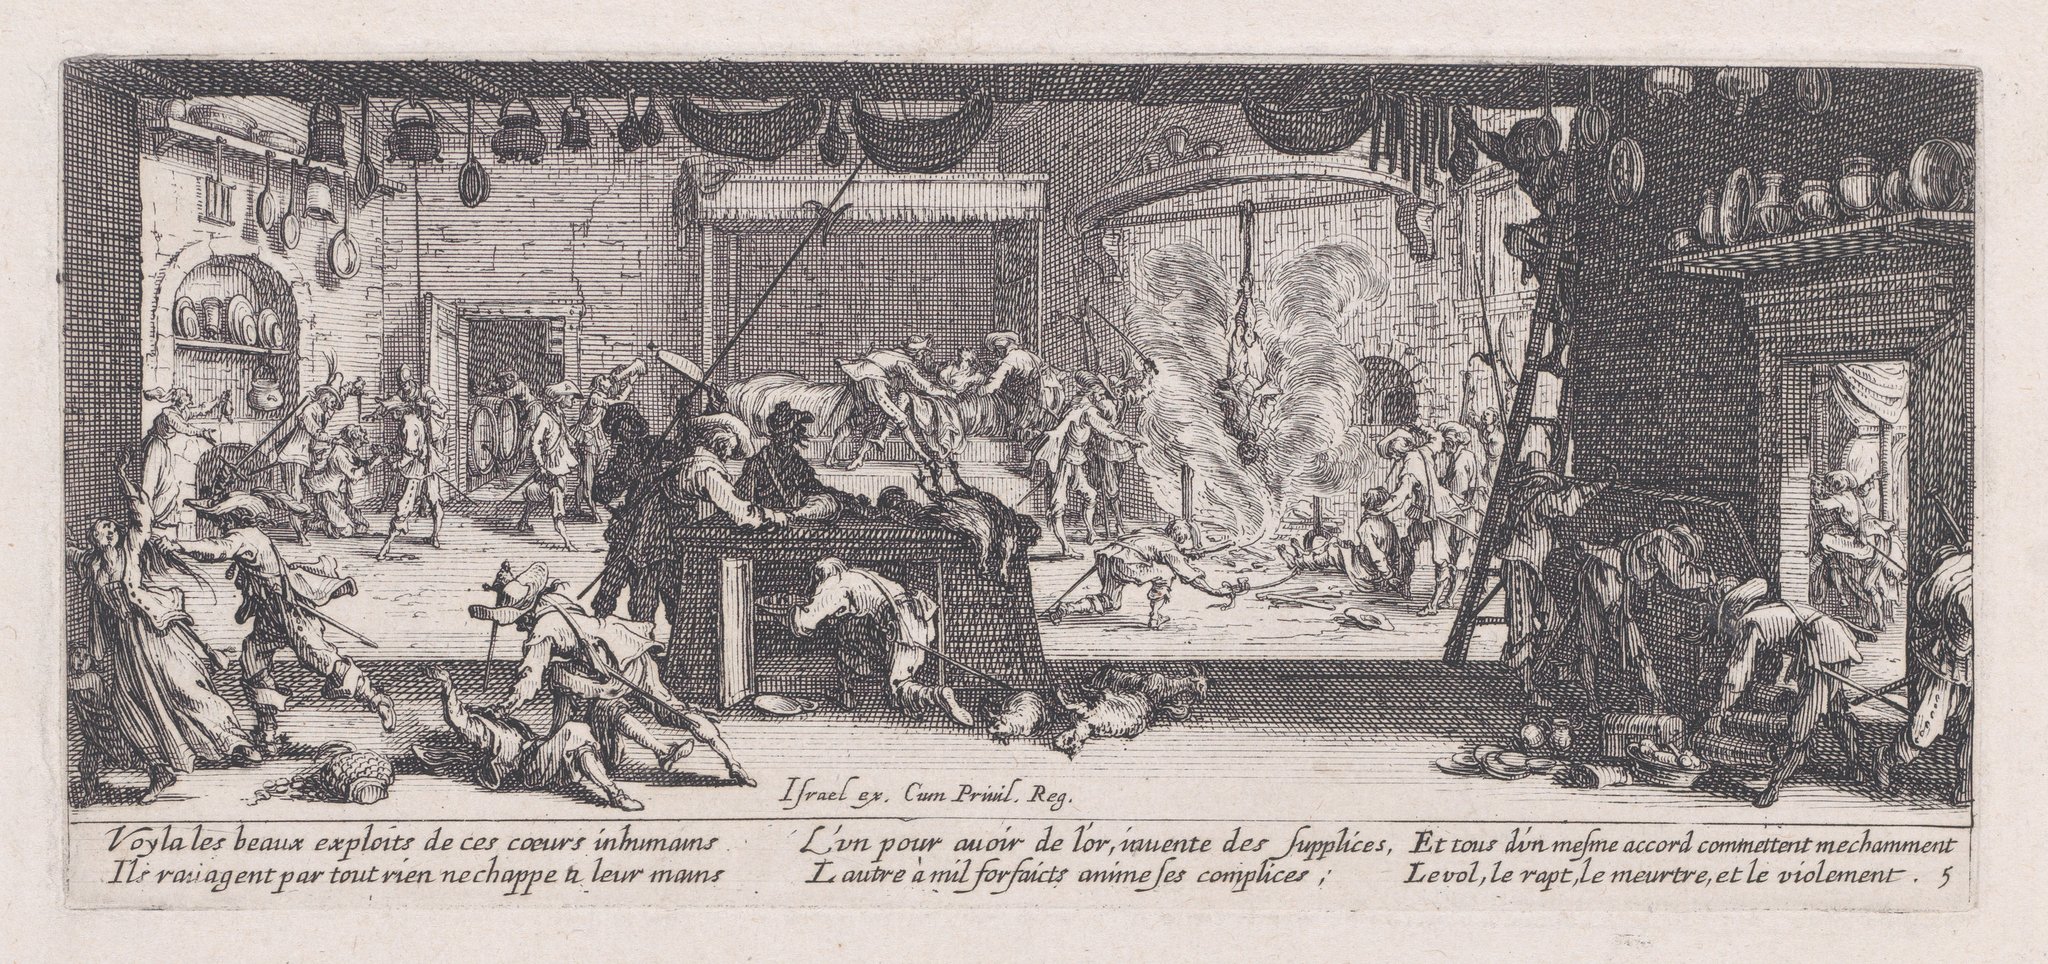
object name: print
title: Le Pillage d'une Ferme (The Looting of a Farm), plate 5 from "Les Misères et les Mal-Heures de la Guerre" (The Miseries and Misfortunes of War)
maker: jacques callot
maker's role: artist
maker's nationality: french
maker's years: 1592-1635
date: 1633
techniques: etching